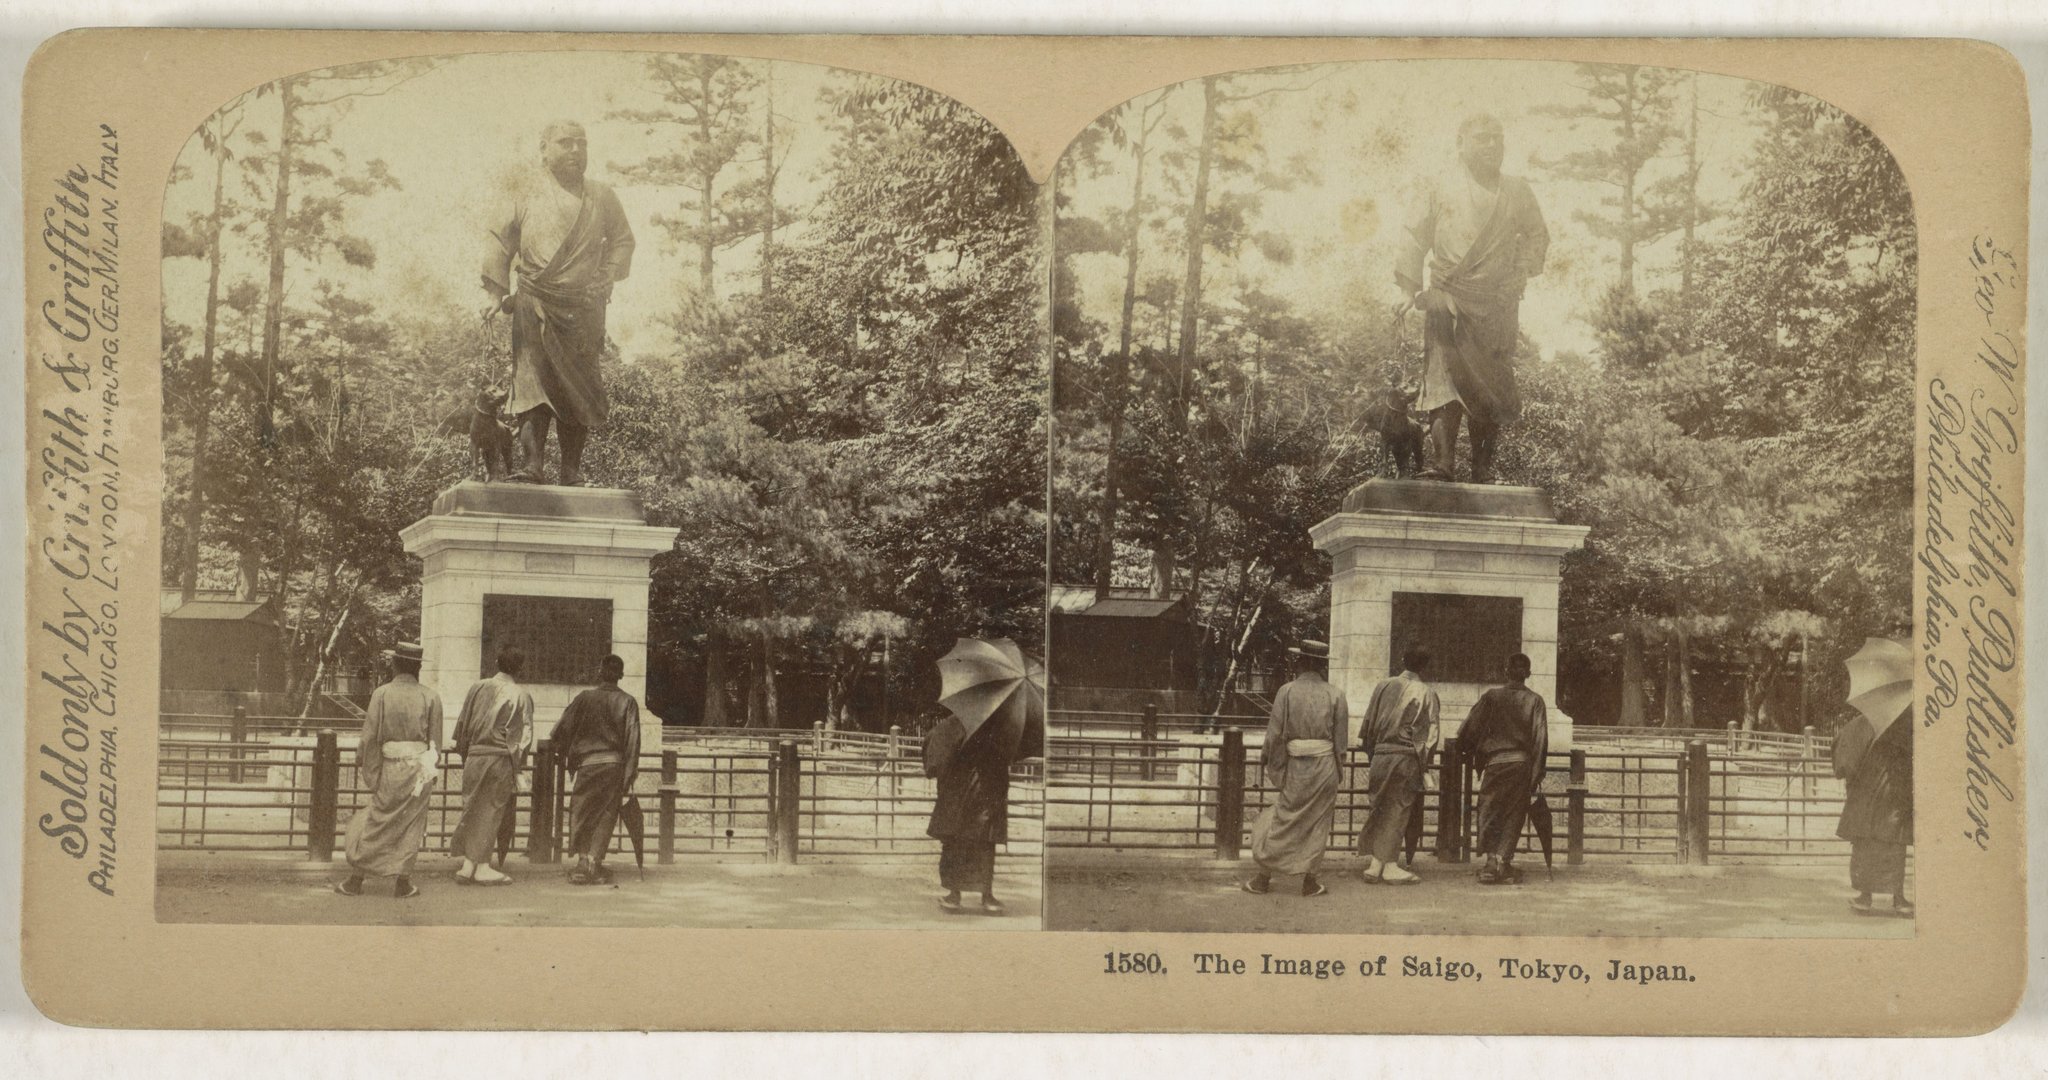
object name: stereograph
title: Standbeeld van Takamori Saigo in Uenopark, Tokyo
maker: Anonymous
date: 1898-1912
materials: cardboard, paper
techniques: albumen print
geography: uenopark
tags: monument, statue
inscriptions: number: ‘30’, number: ‘63’, number: ‘1580.’